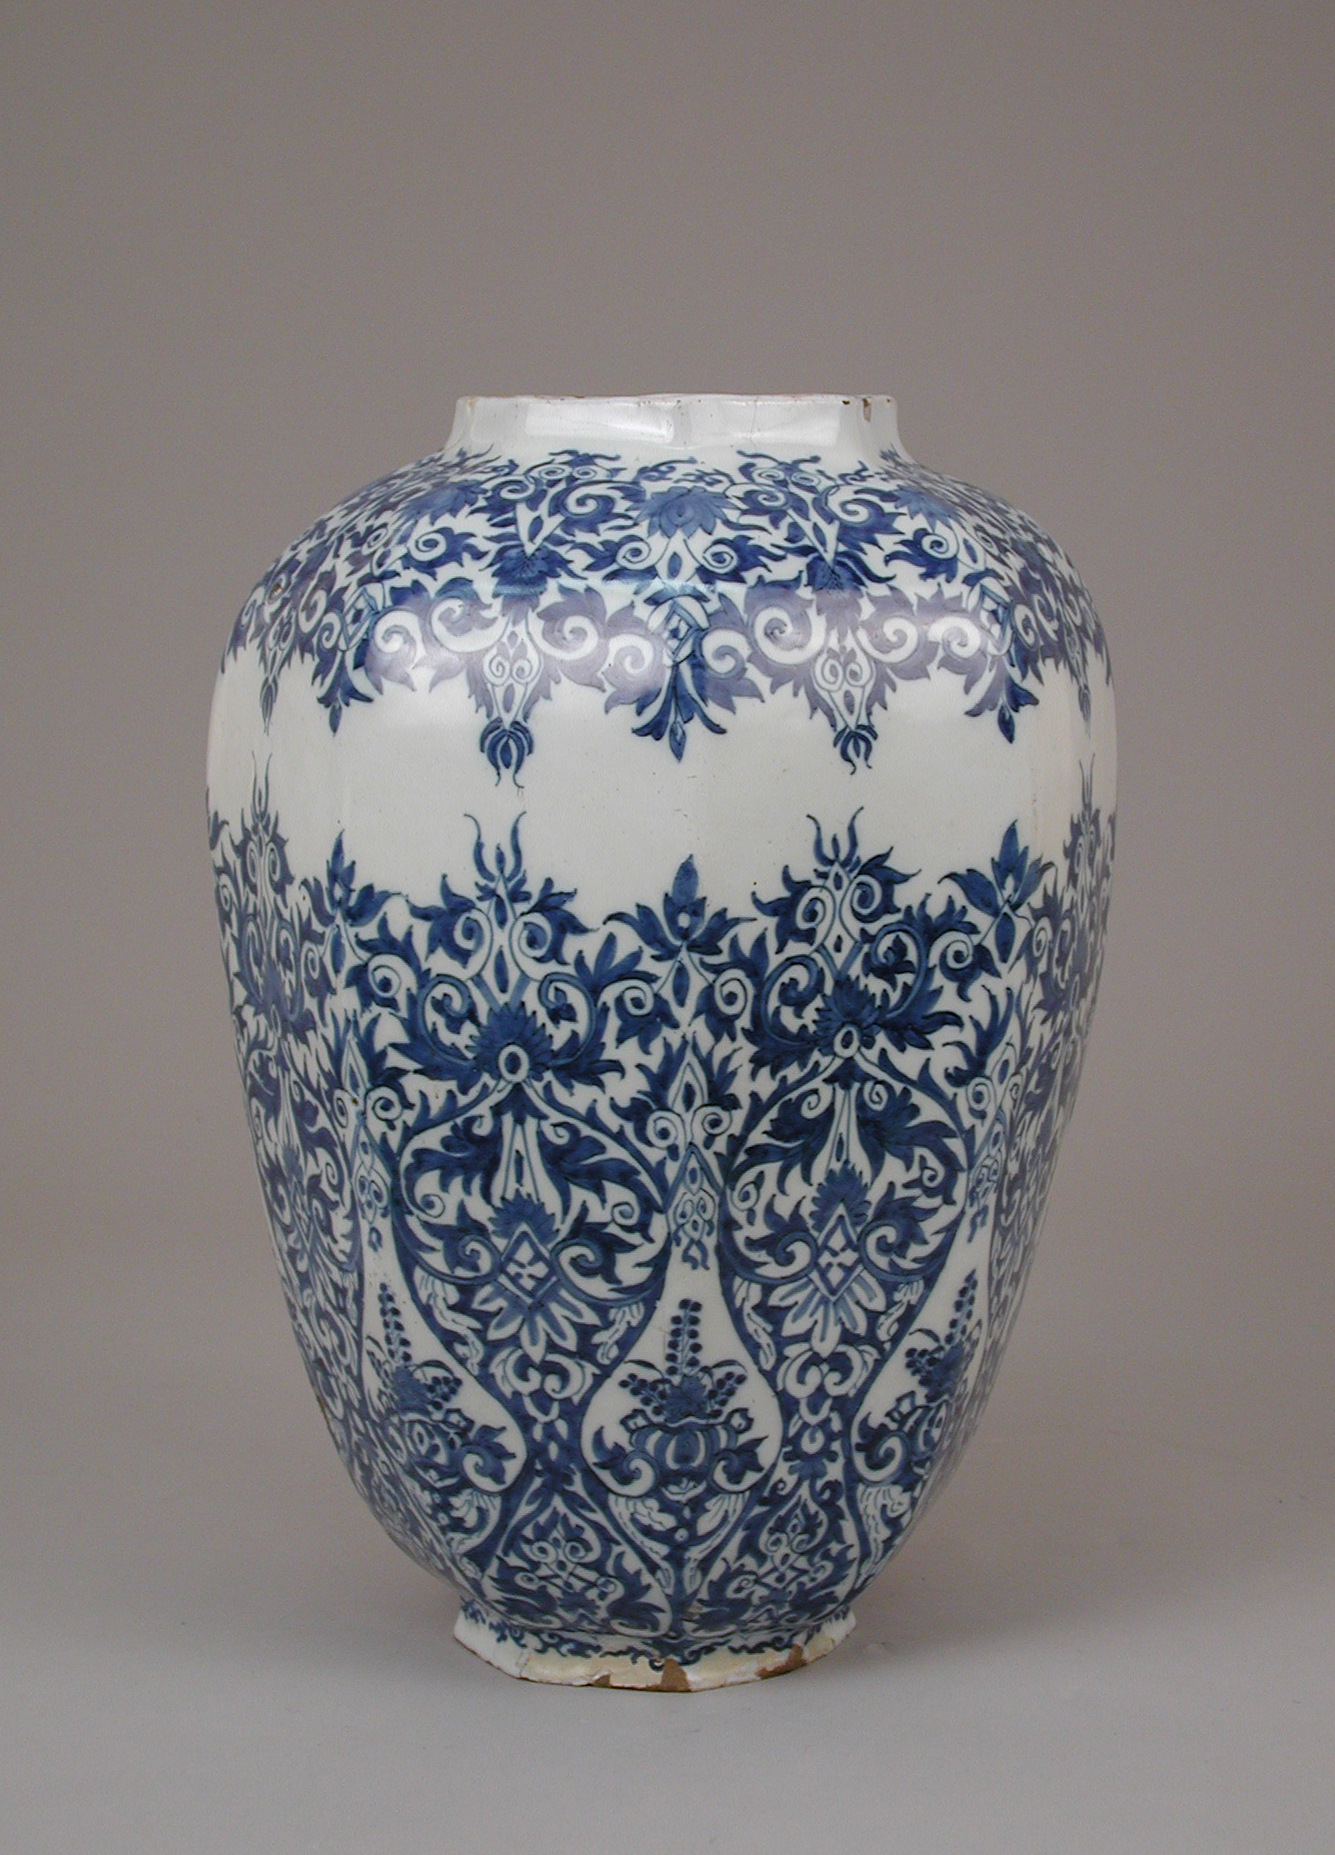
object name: vase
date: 1701-1750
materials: earthenware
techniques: glazing